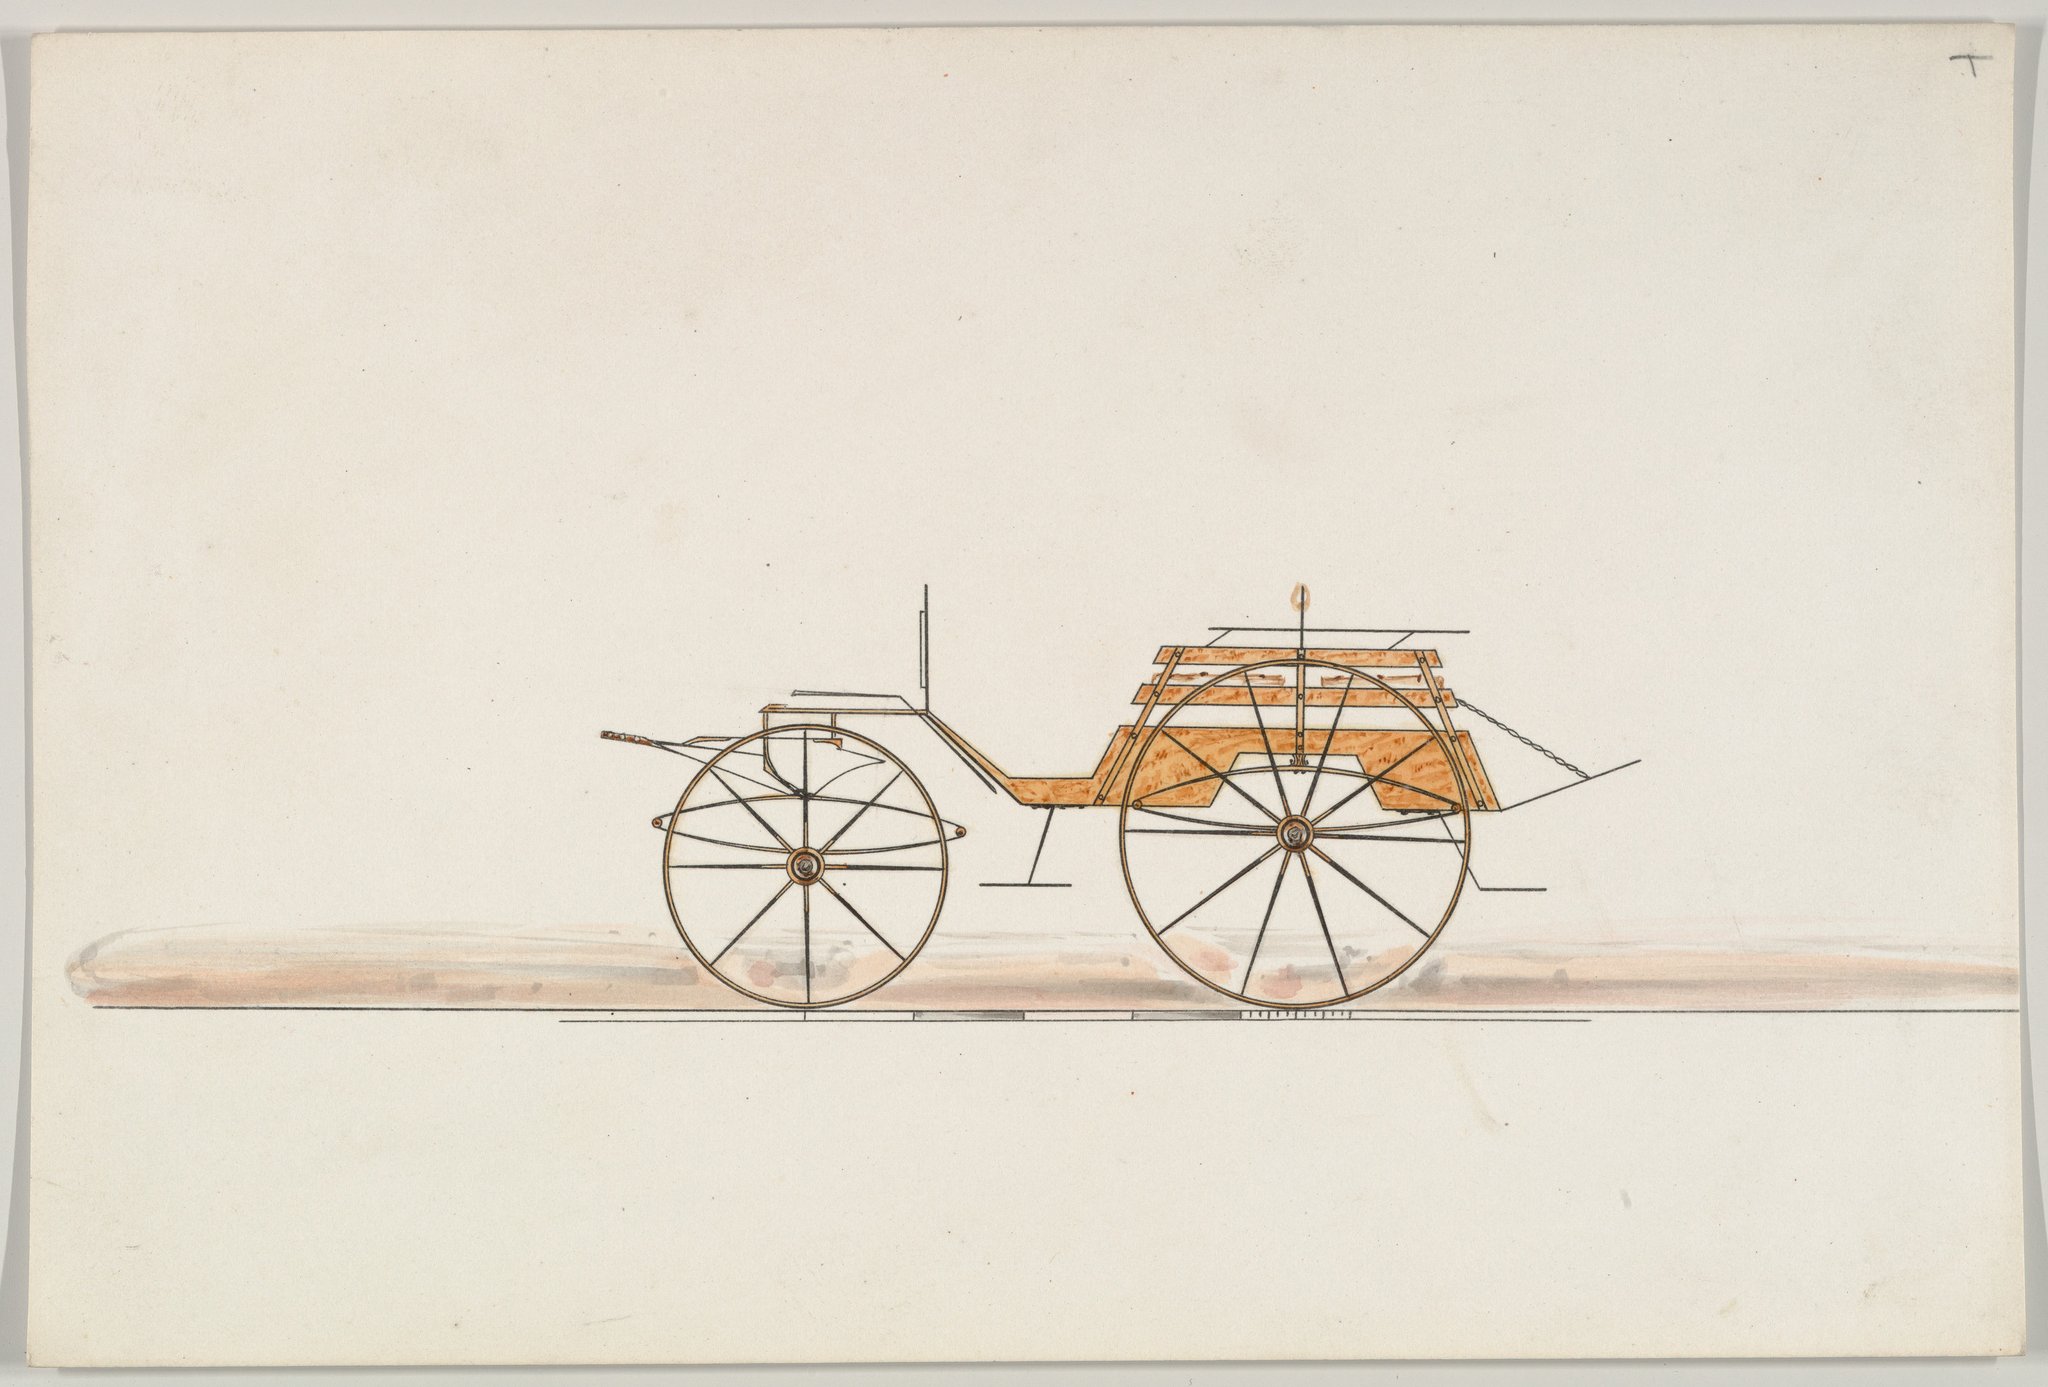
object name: drawing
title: Design for Slat Side Phaeton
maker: brewster & co.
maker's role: manufacturer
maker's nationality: american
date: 1850-1870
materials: gouache, gum arabic, ink, watercolor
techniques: pen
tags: carriages